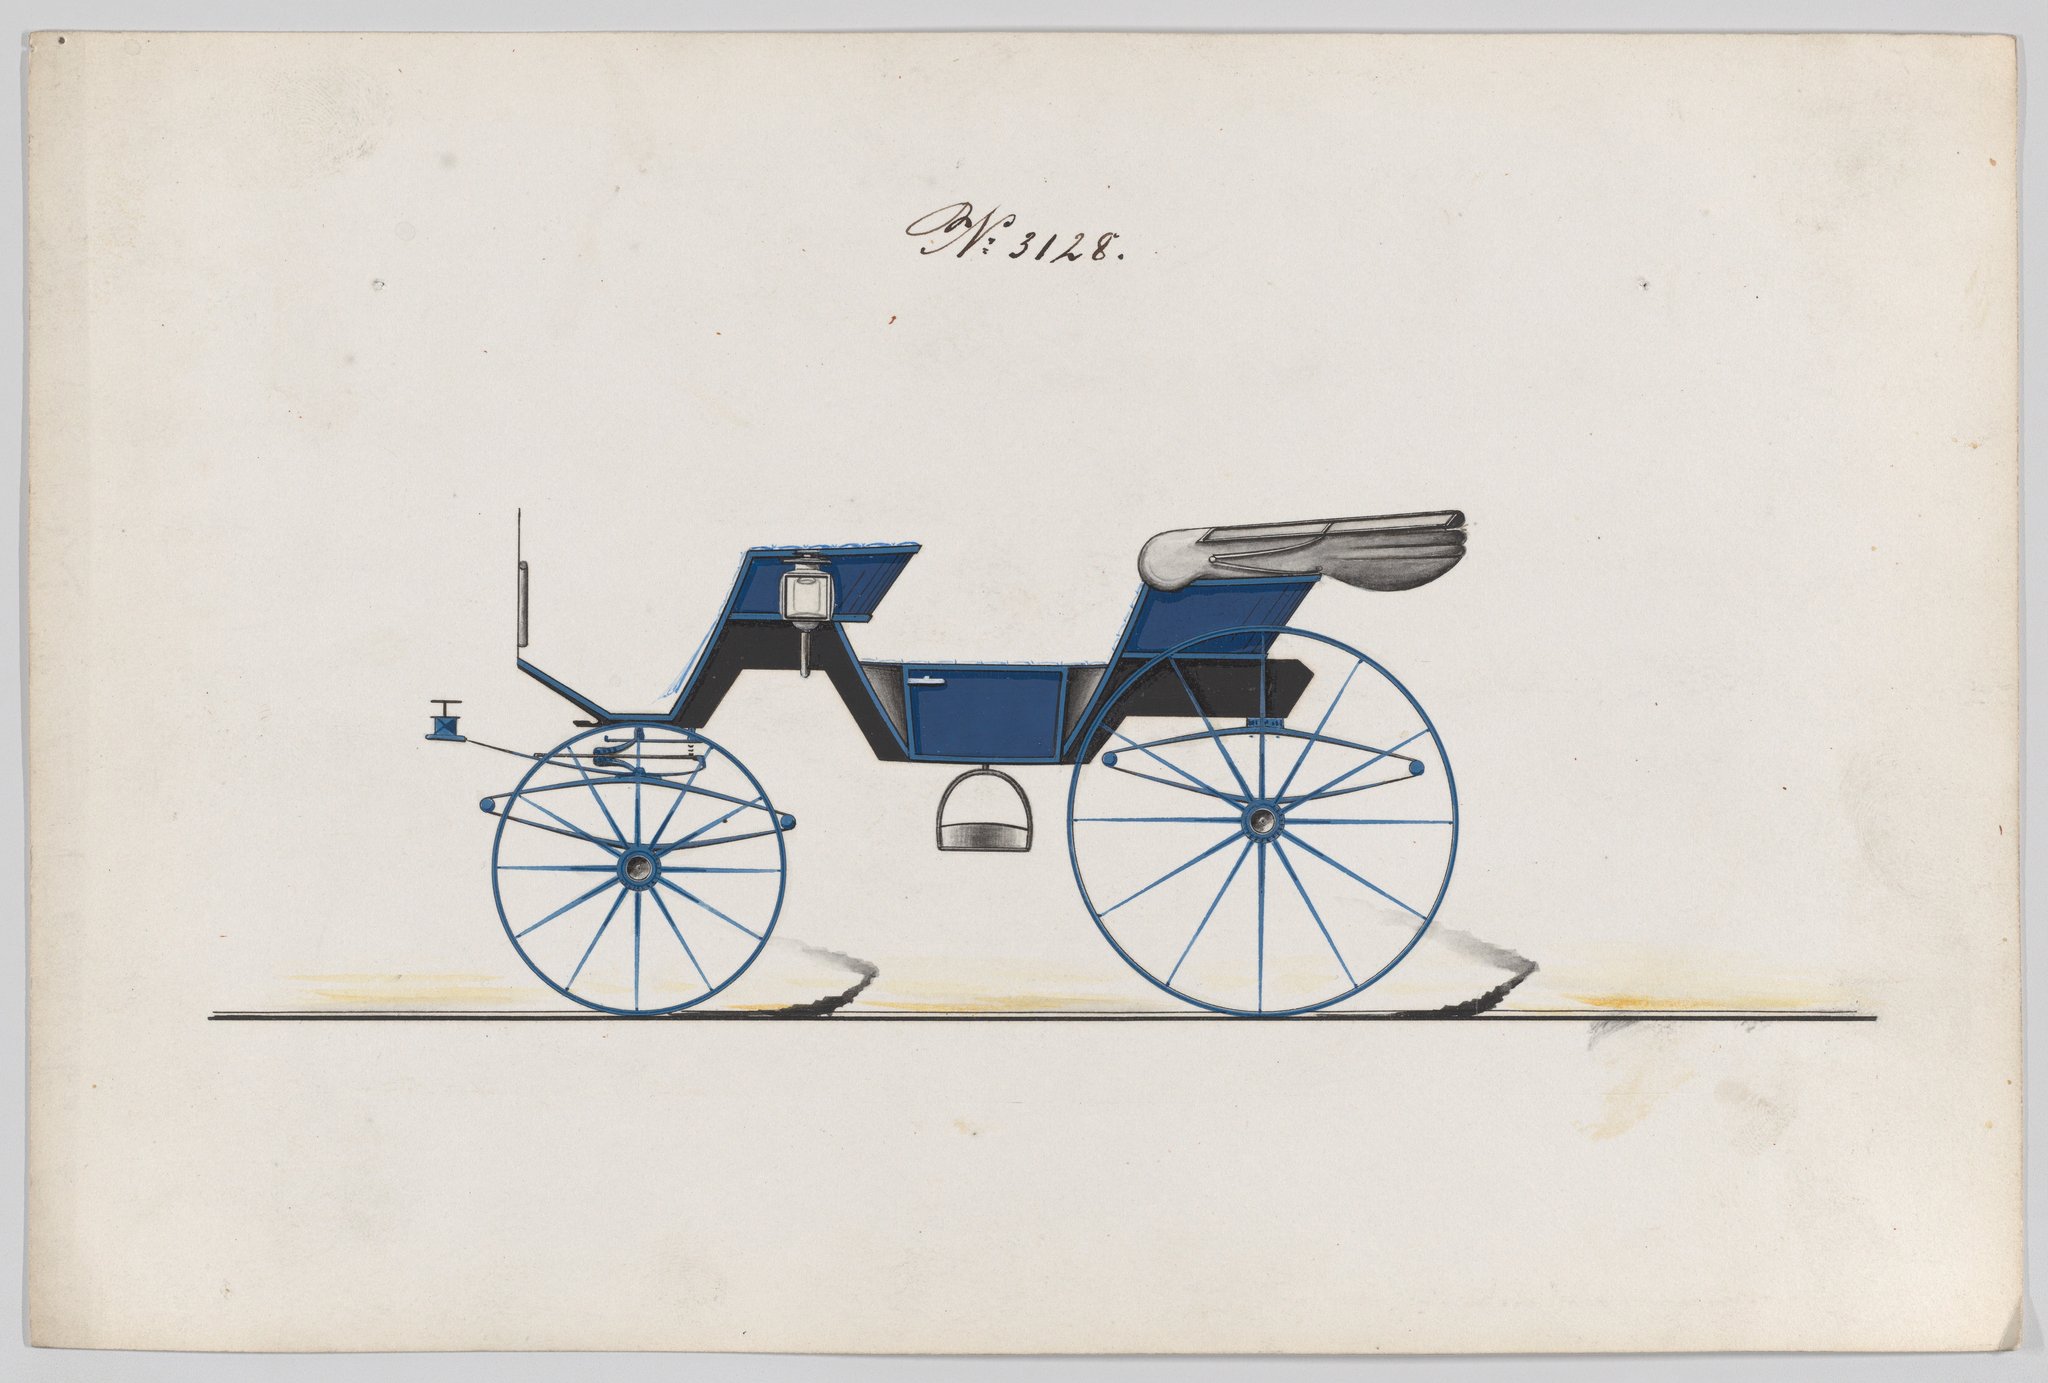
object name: drawing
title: Design for Cabriolet Phaeton, no. 3128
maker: brewster & co.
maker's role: manufacturer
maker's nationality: american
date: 1875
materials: gouache, ink, watercolor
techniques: pen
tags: carriages